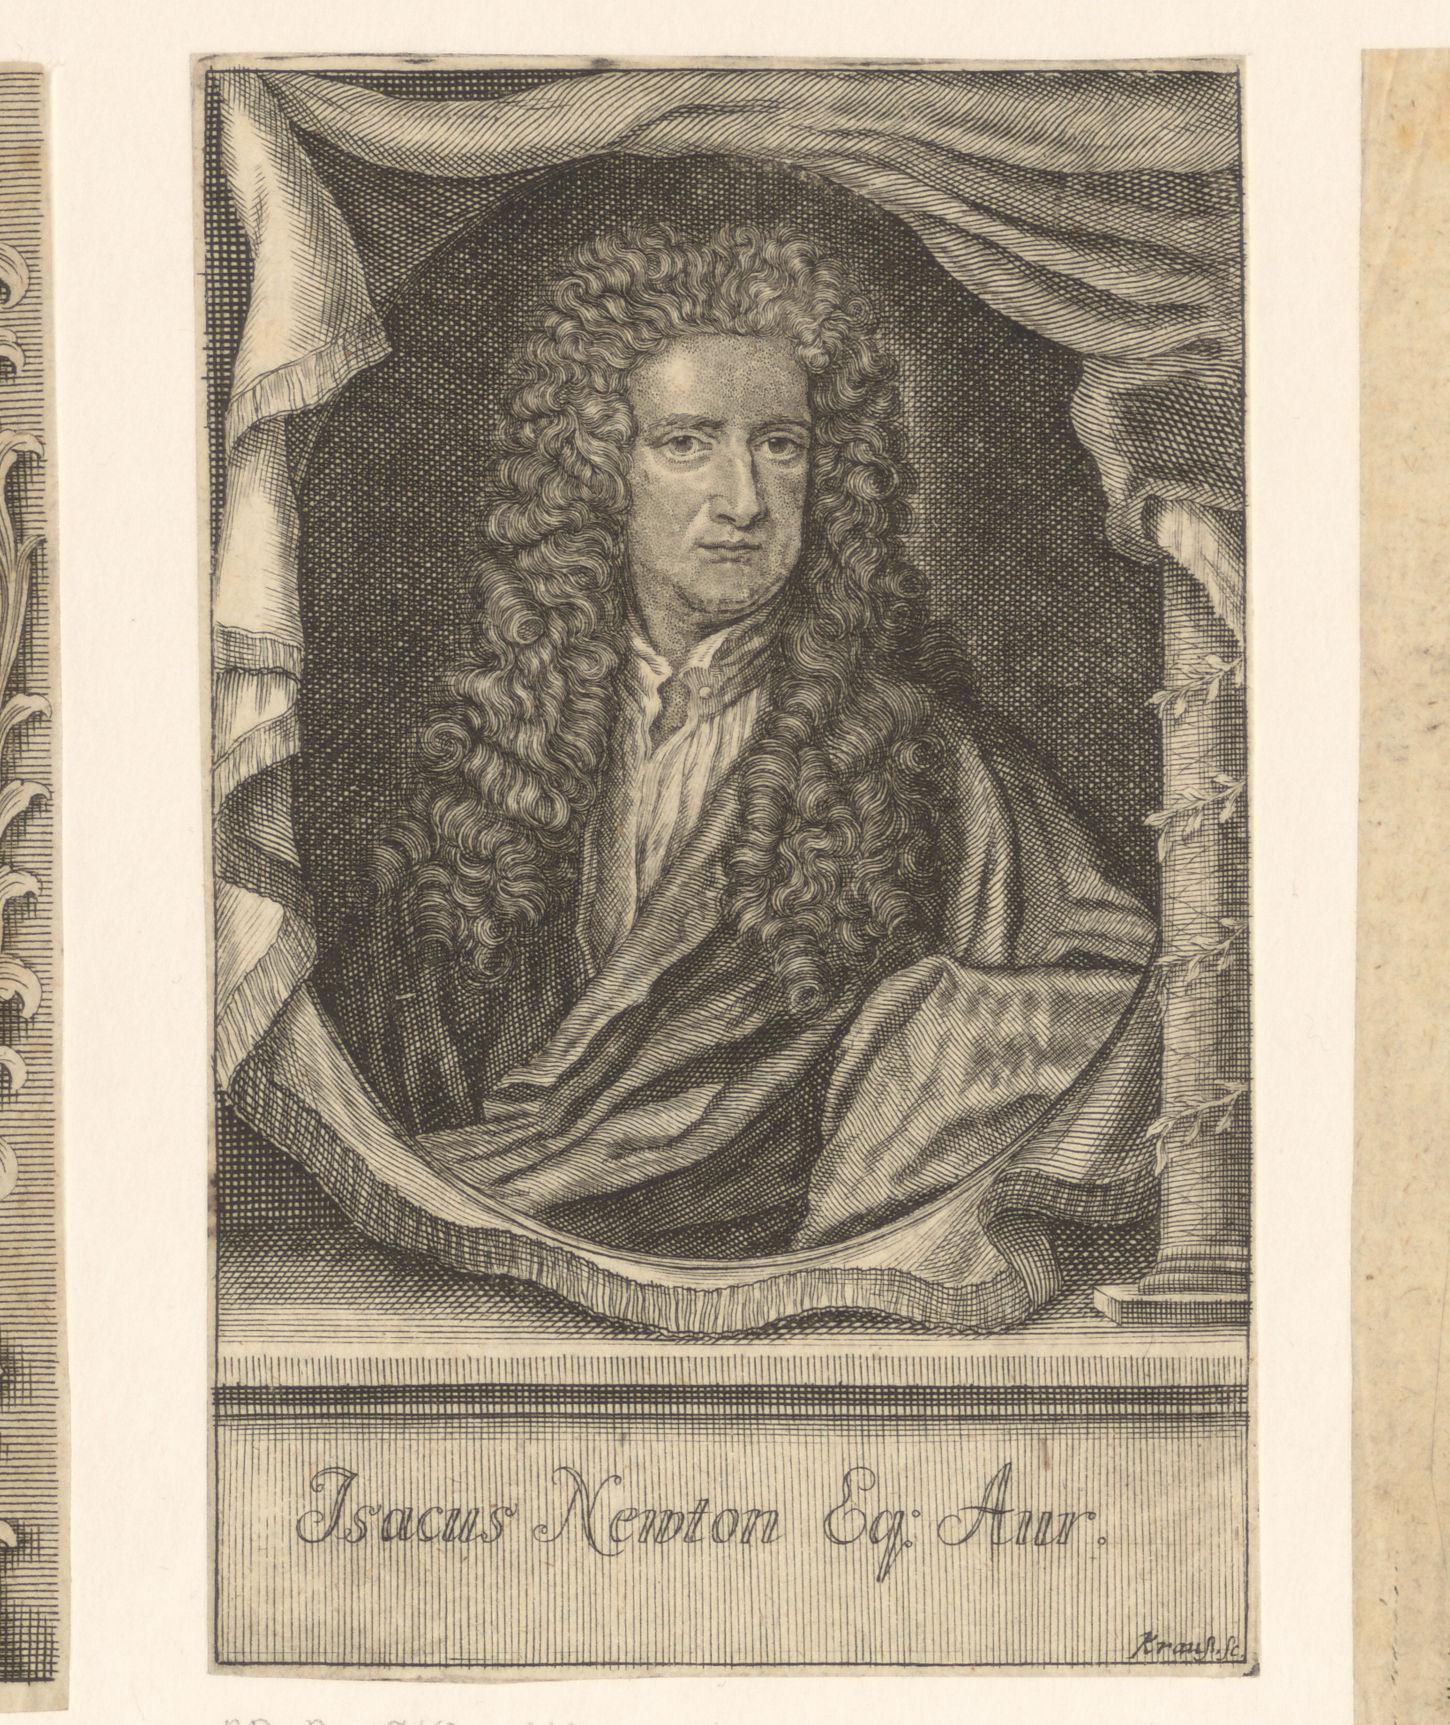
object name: print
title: Portret van Sir Isaac Newton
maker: jodocus egidius krauss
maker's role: print maker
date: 1705-1753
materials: paper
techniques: engraving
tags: london, astronomy (and cosmography) (+ portrait of scholar, scientist), scholar, philosopher, physics and mechanics (+ portrait of scholar, scientist), historical persons, mathematics (+ portrait of scholar, scientist)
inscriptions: collector's mark: Lugt 2228